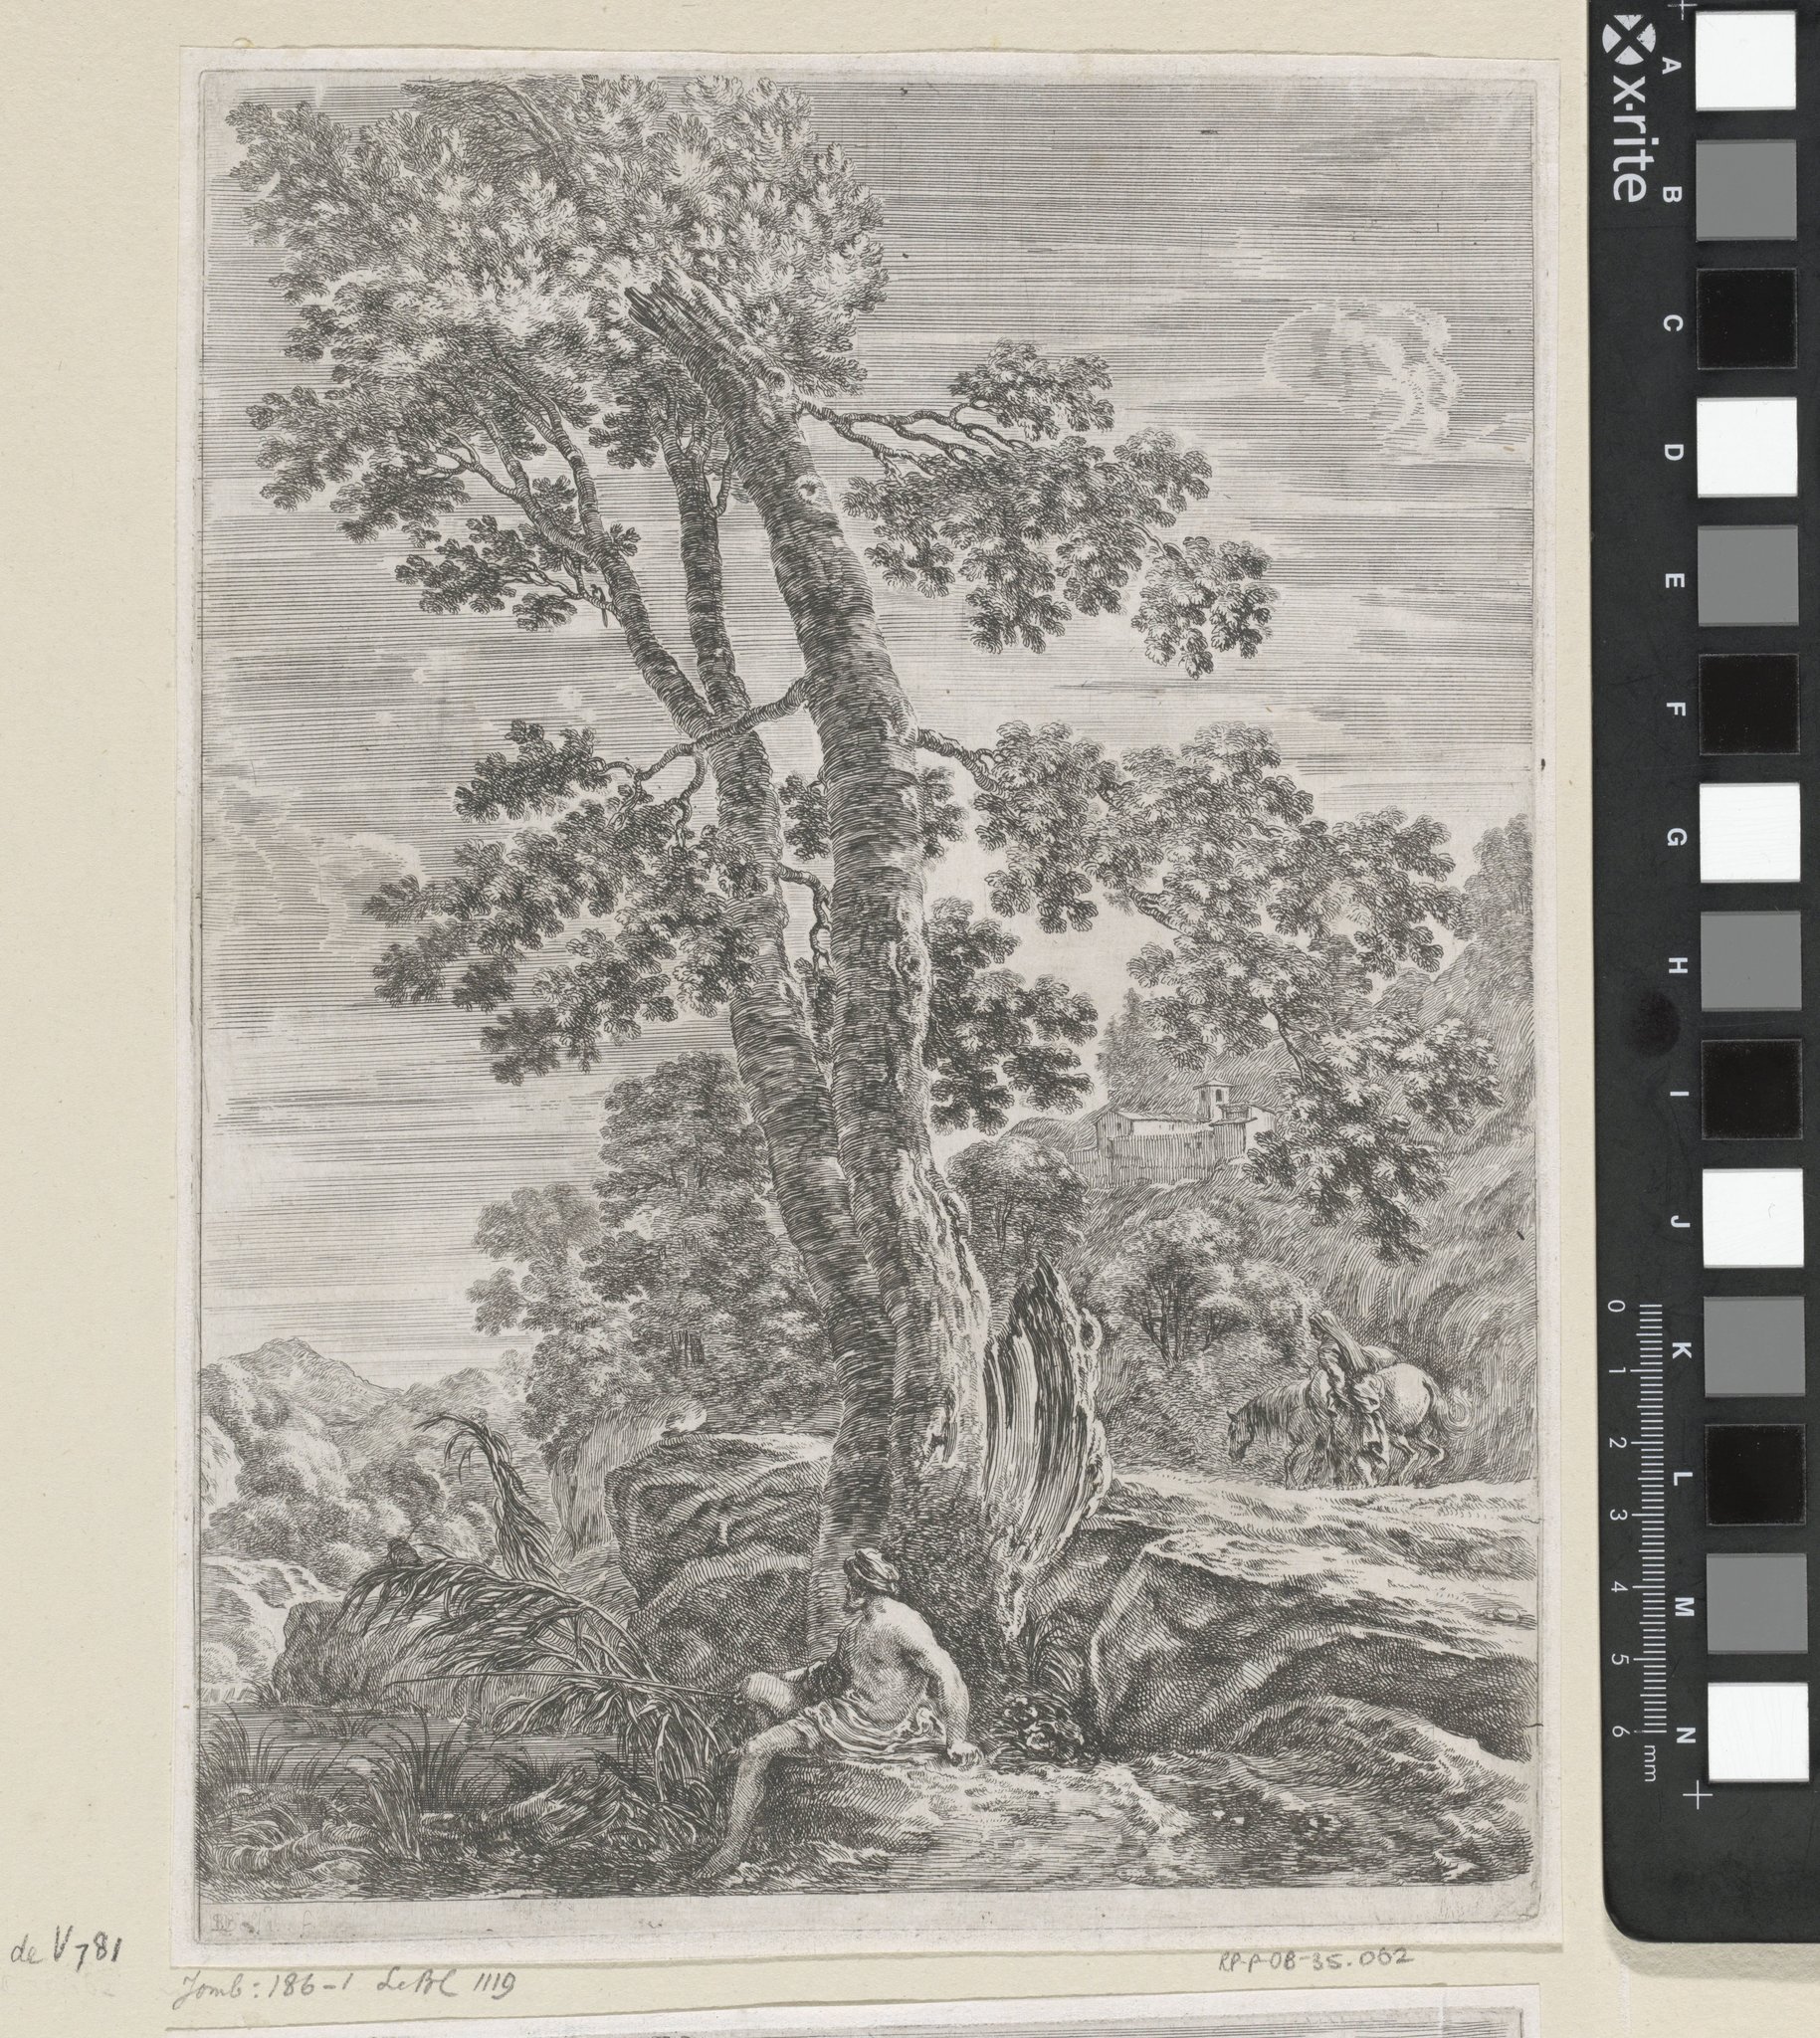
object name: print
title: Vier landschappen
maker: stefano della bella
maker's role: draughtsman, print maker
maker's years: 1610-1664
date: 1620-1664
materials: paper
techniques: etching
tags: landscapes, fishing (sports), fisherman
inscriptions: collector's mark: Lugt 240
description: Een landschap met een vissende man onder een boom. Op de achtergrond rechts een vrouw met paard en huizen op een heuvel.